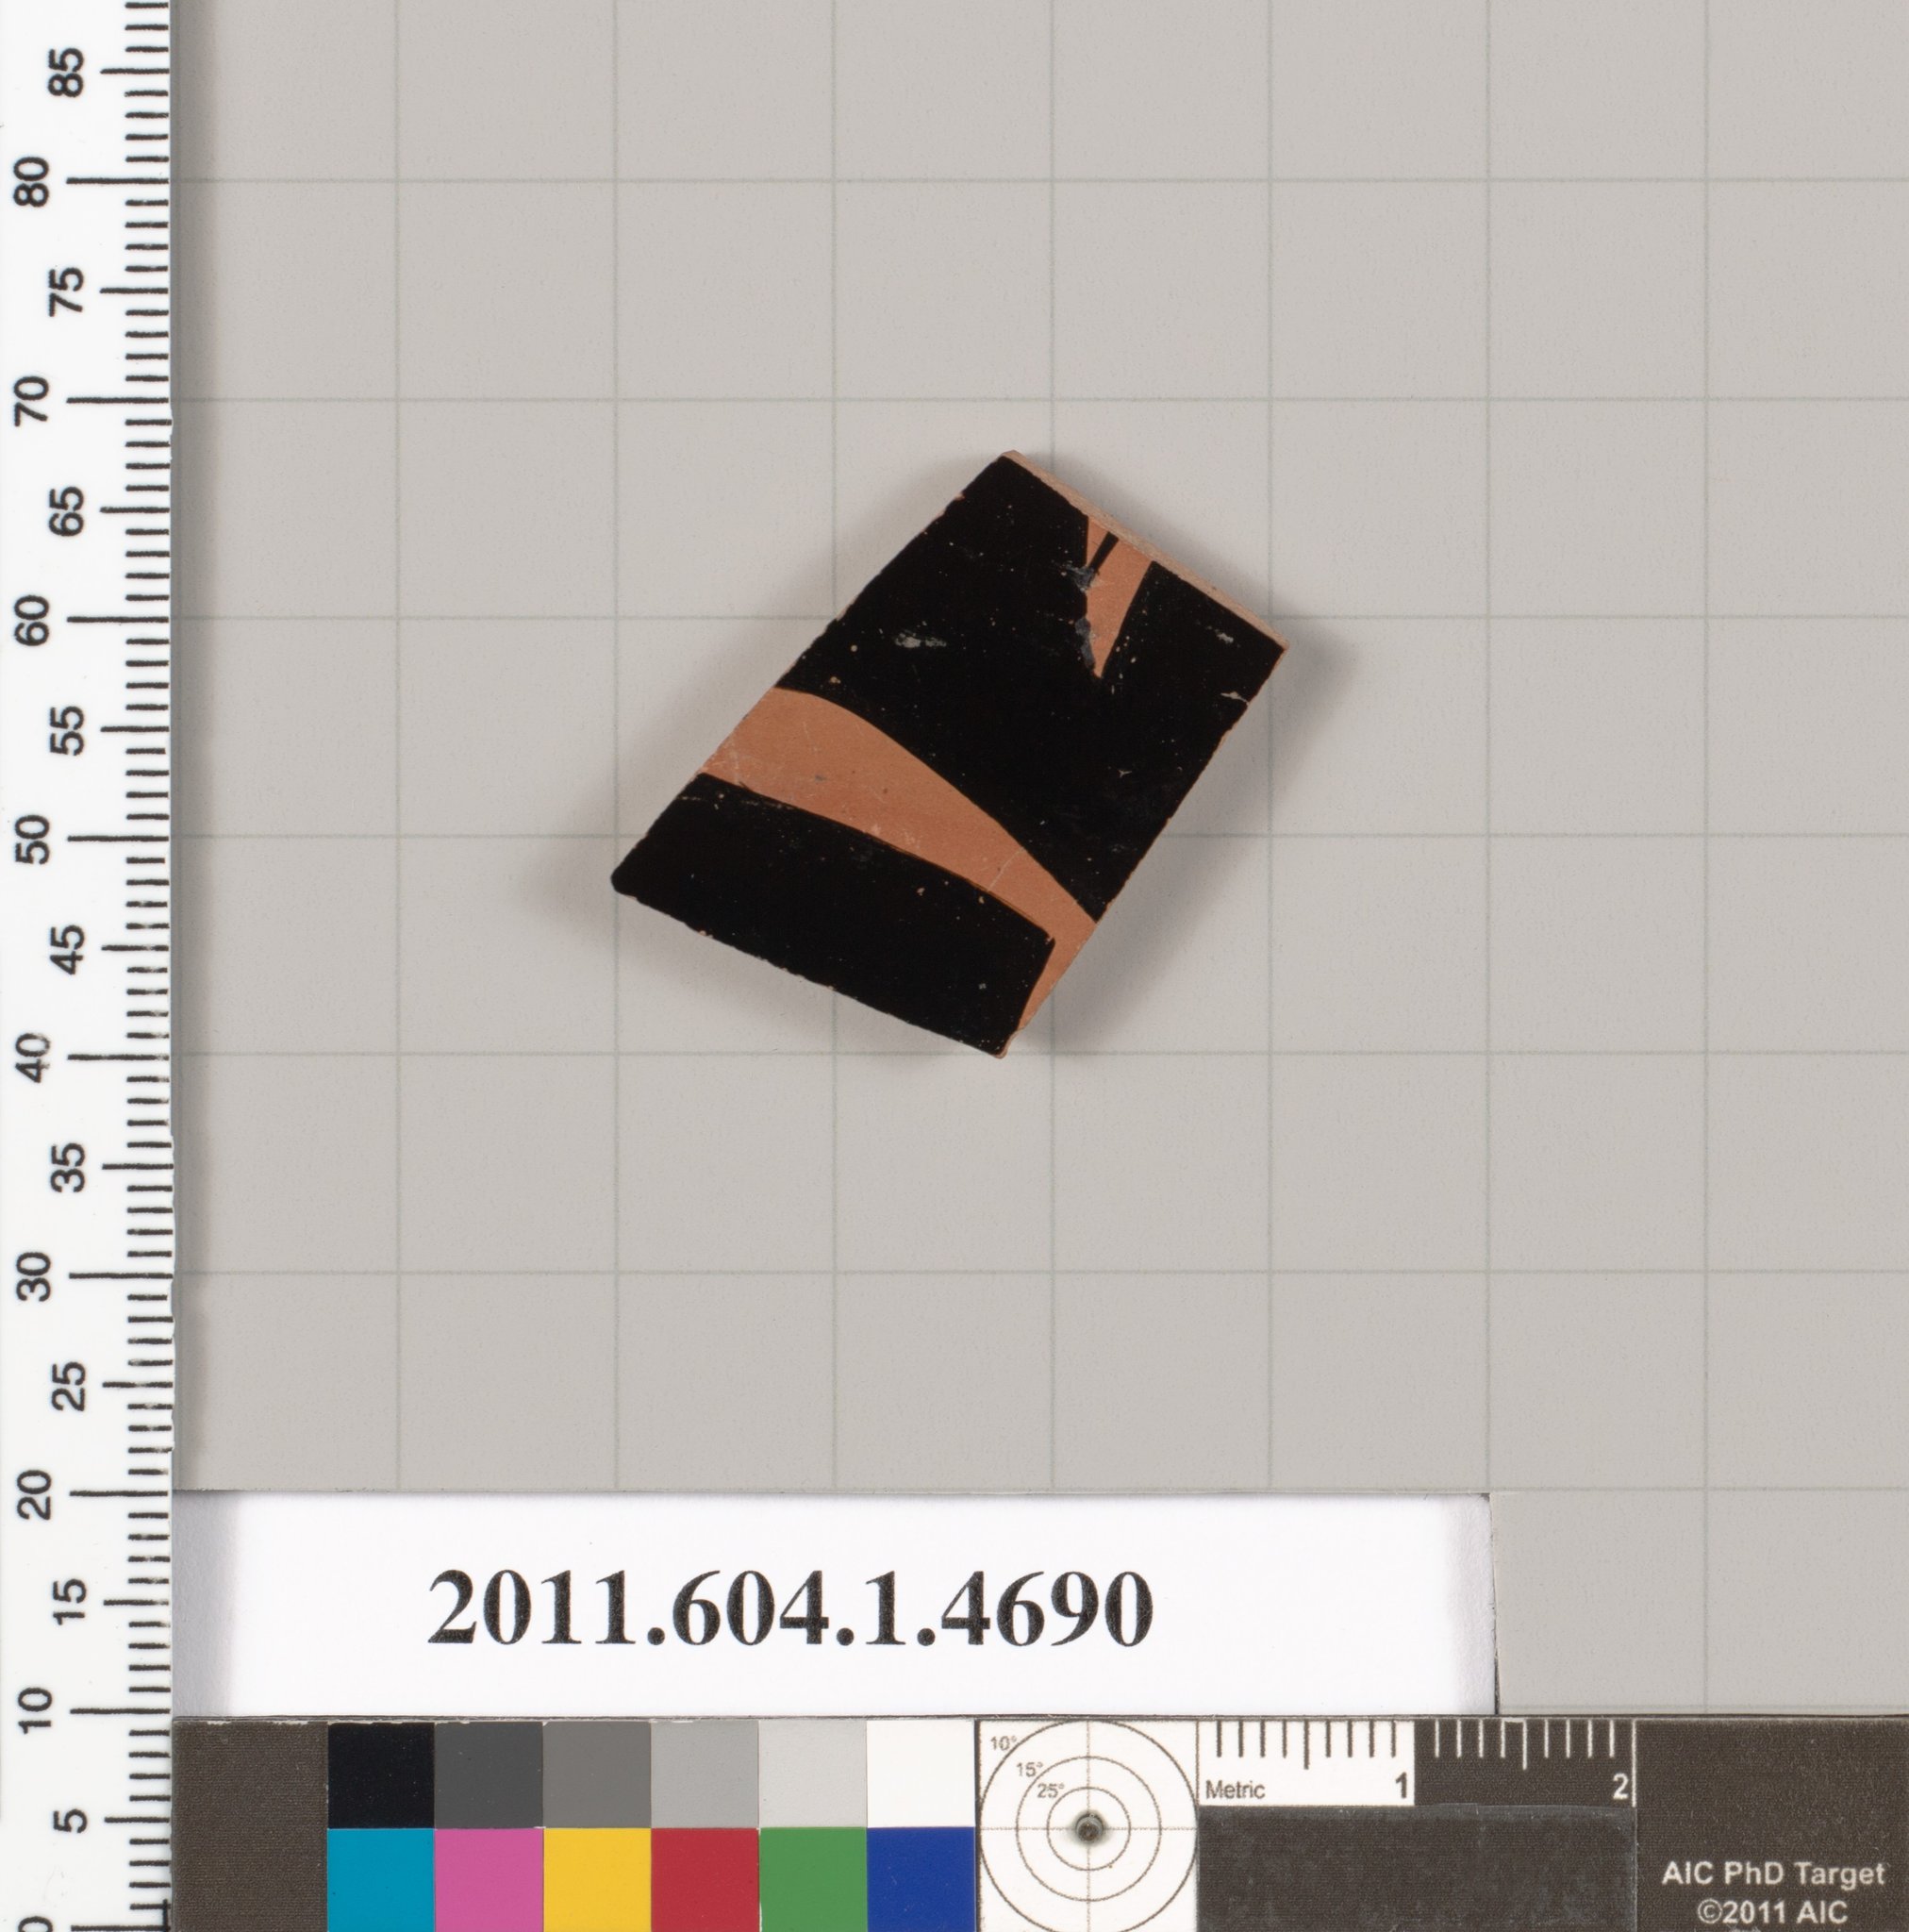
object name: kylix fragment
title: Terracotta fragment of a kylix (drinking cup)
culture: greek, attic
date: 500-470 BCE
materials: terracotta